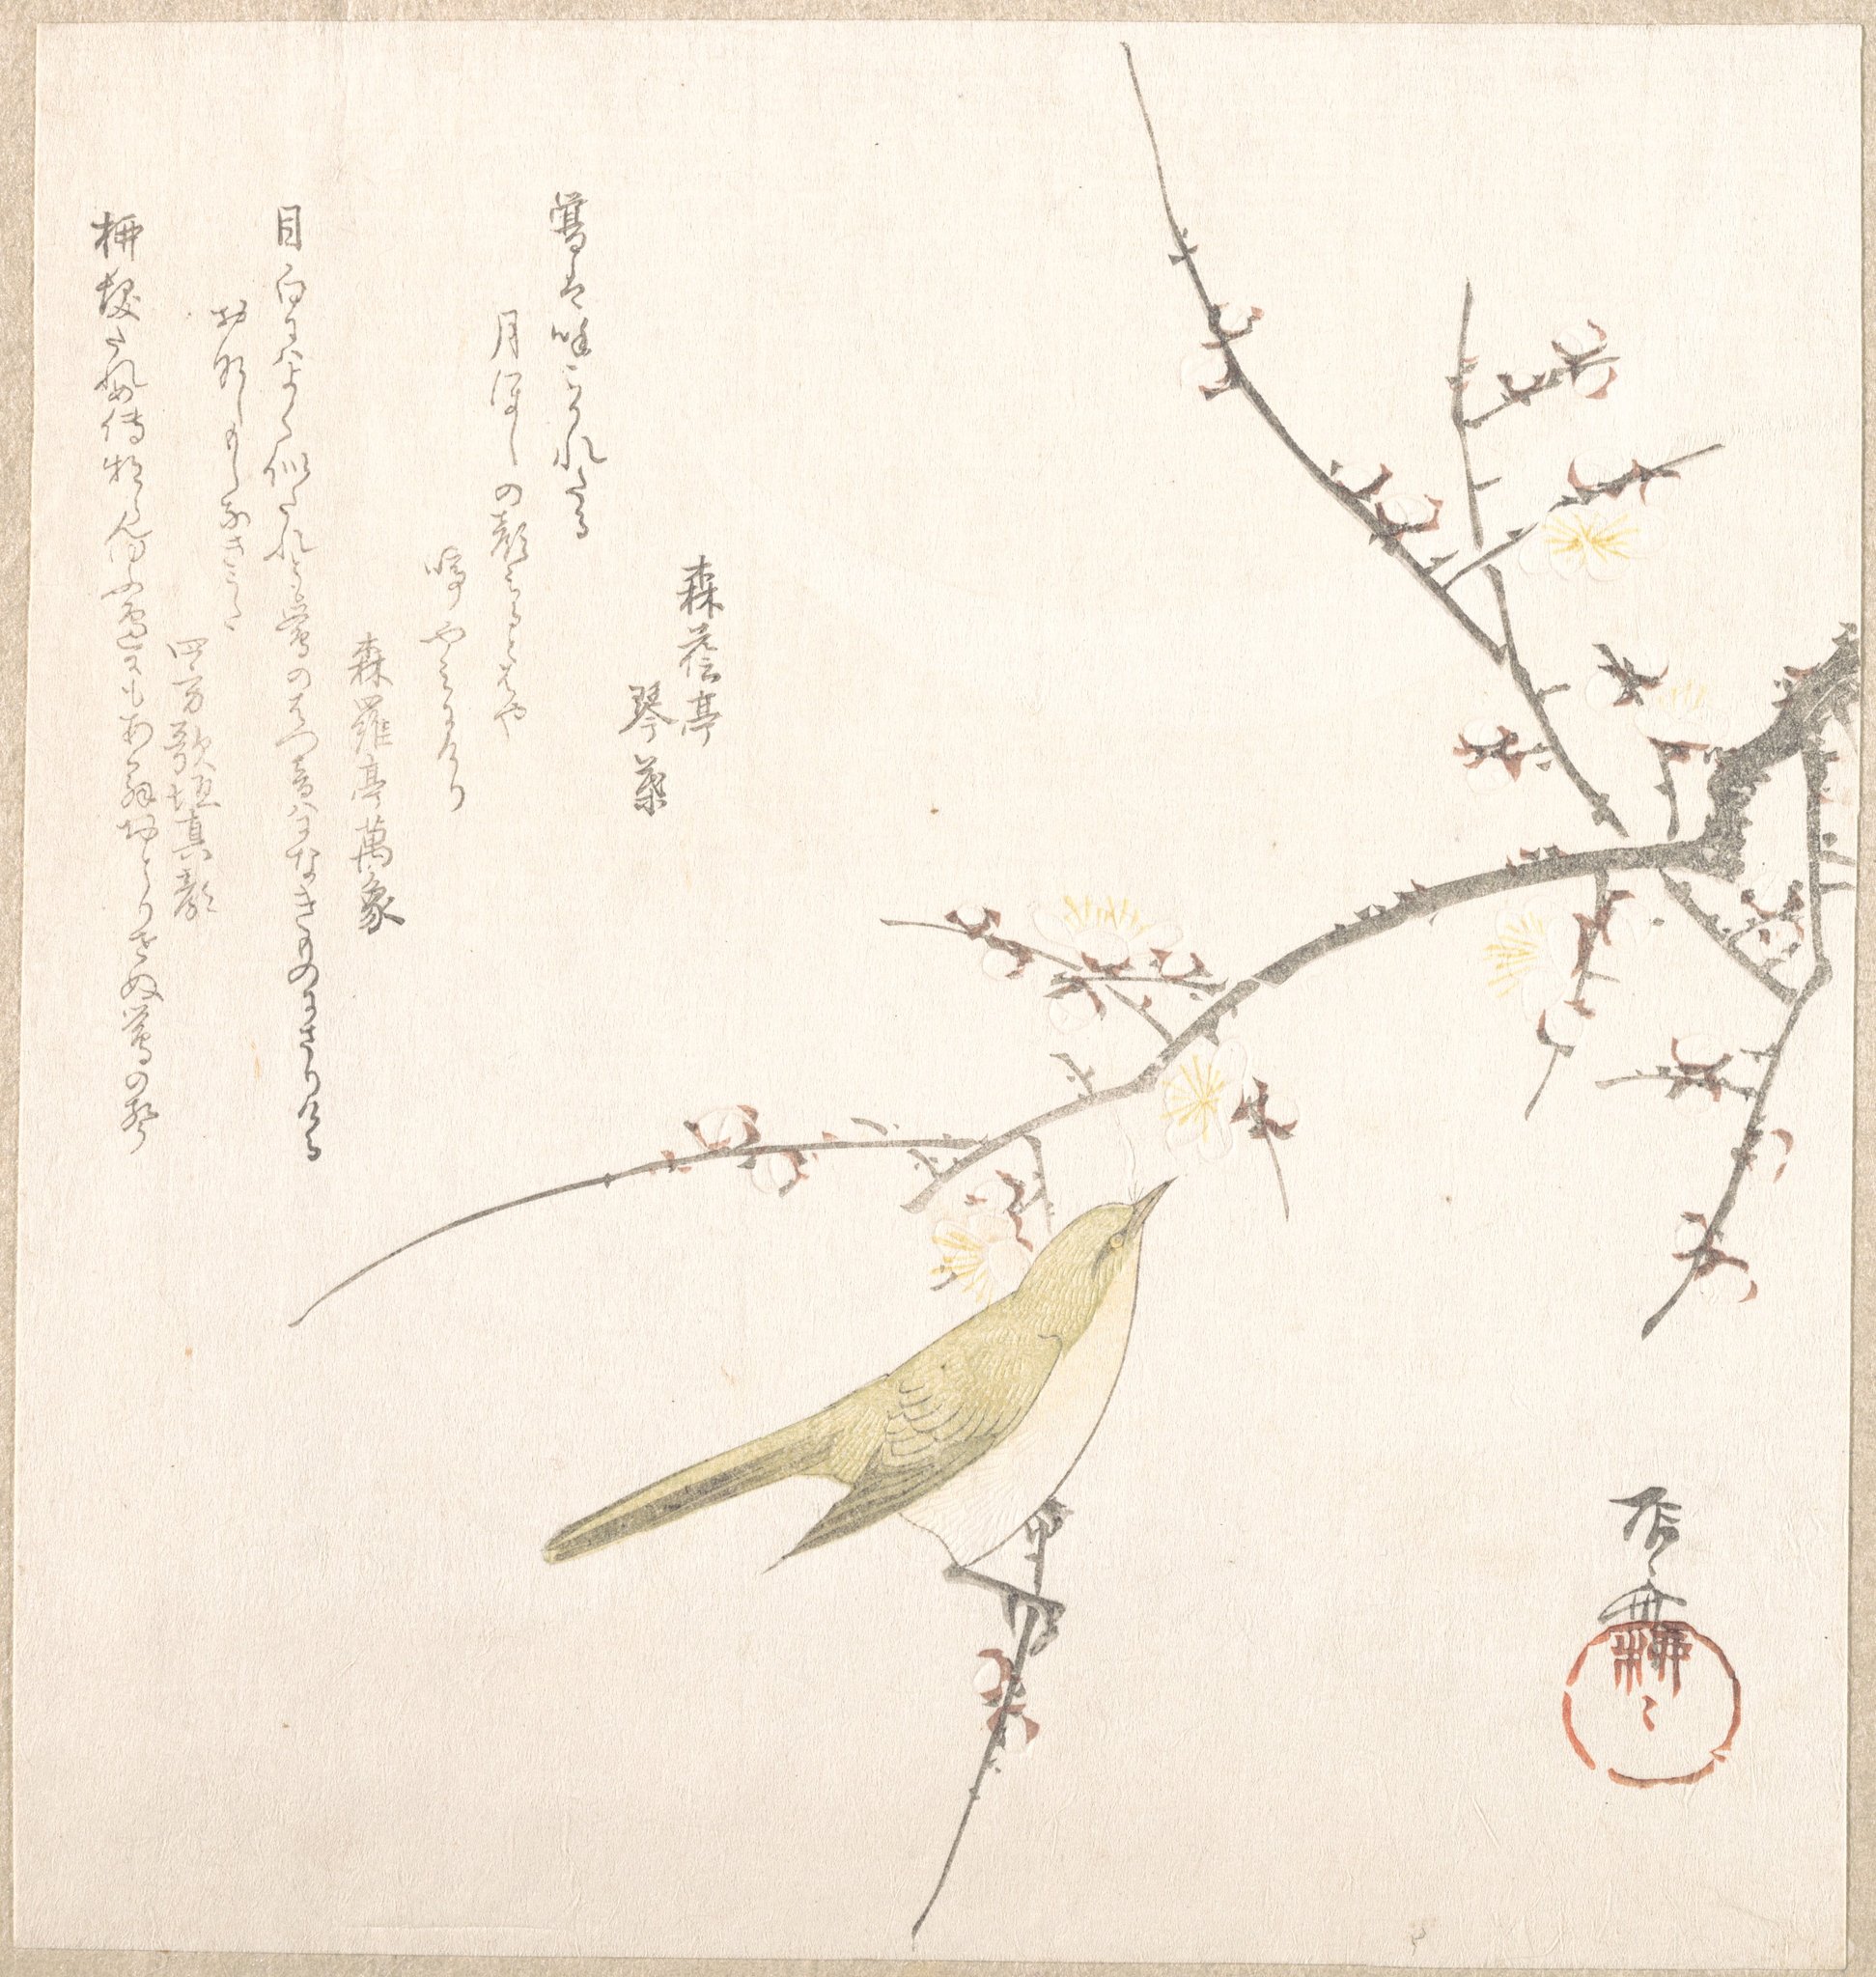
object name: woodblock print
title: New Moon; Nightingale on a Plum Branch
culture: japanese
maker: ryūryūkyo shinsai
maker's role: artist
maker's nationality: japanese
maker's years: 1799-1823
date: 1801-1900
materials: ink, paper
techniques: surimono, woodblock print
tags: birds,trees